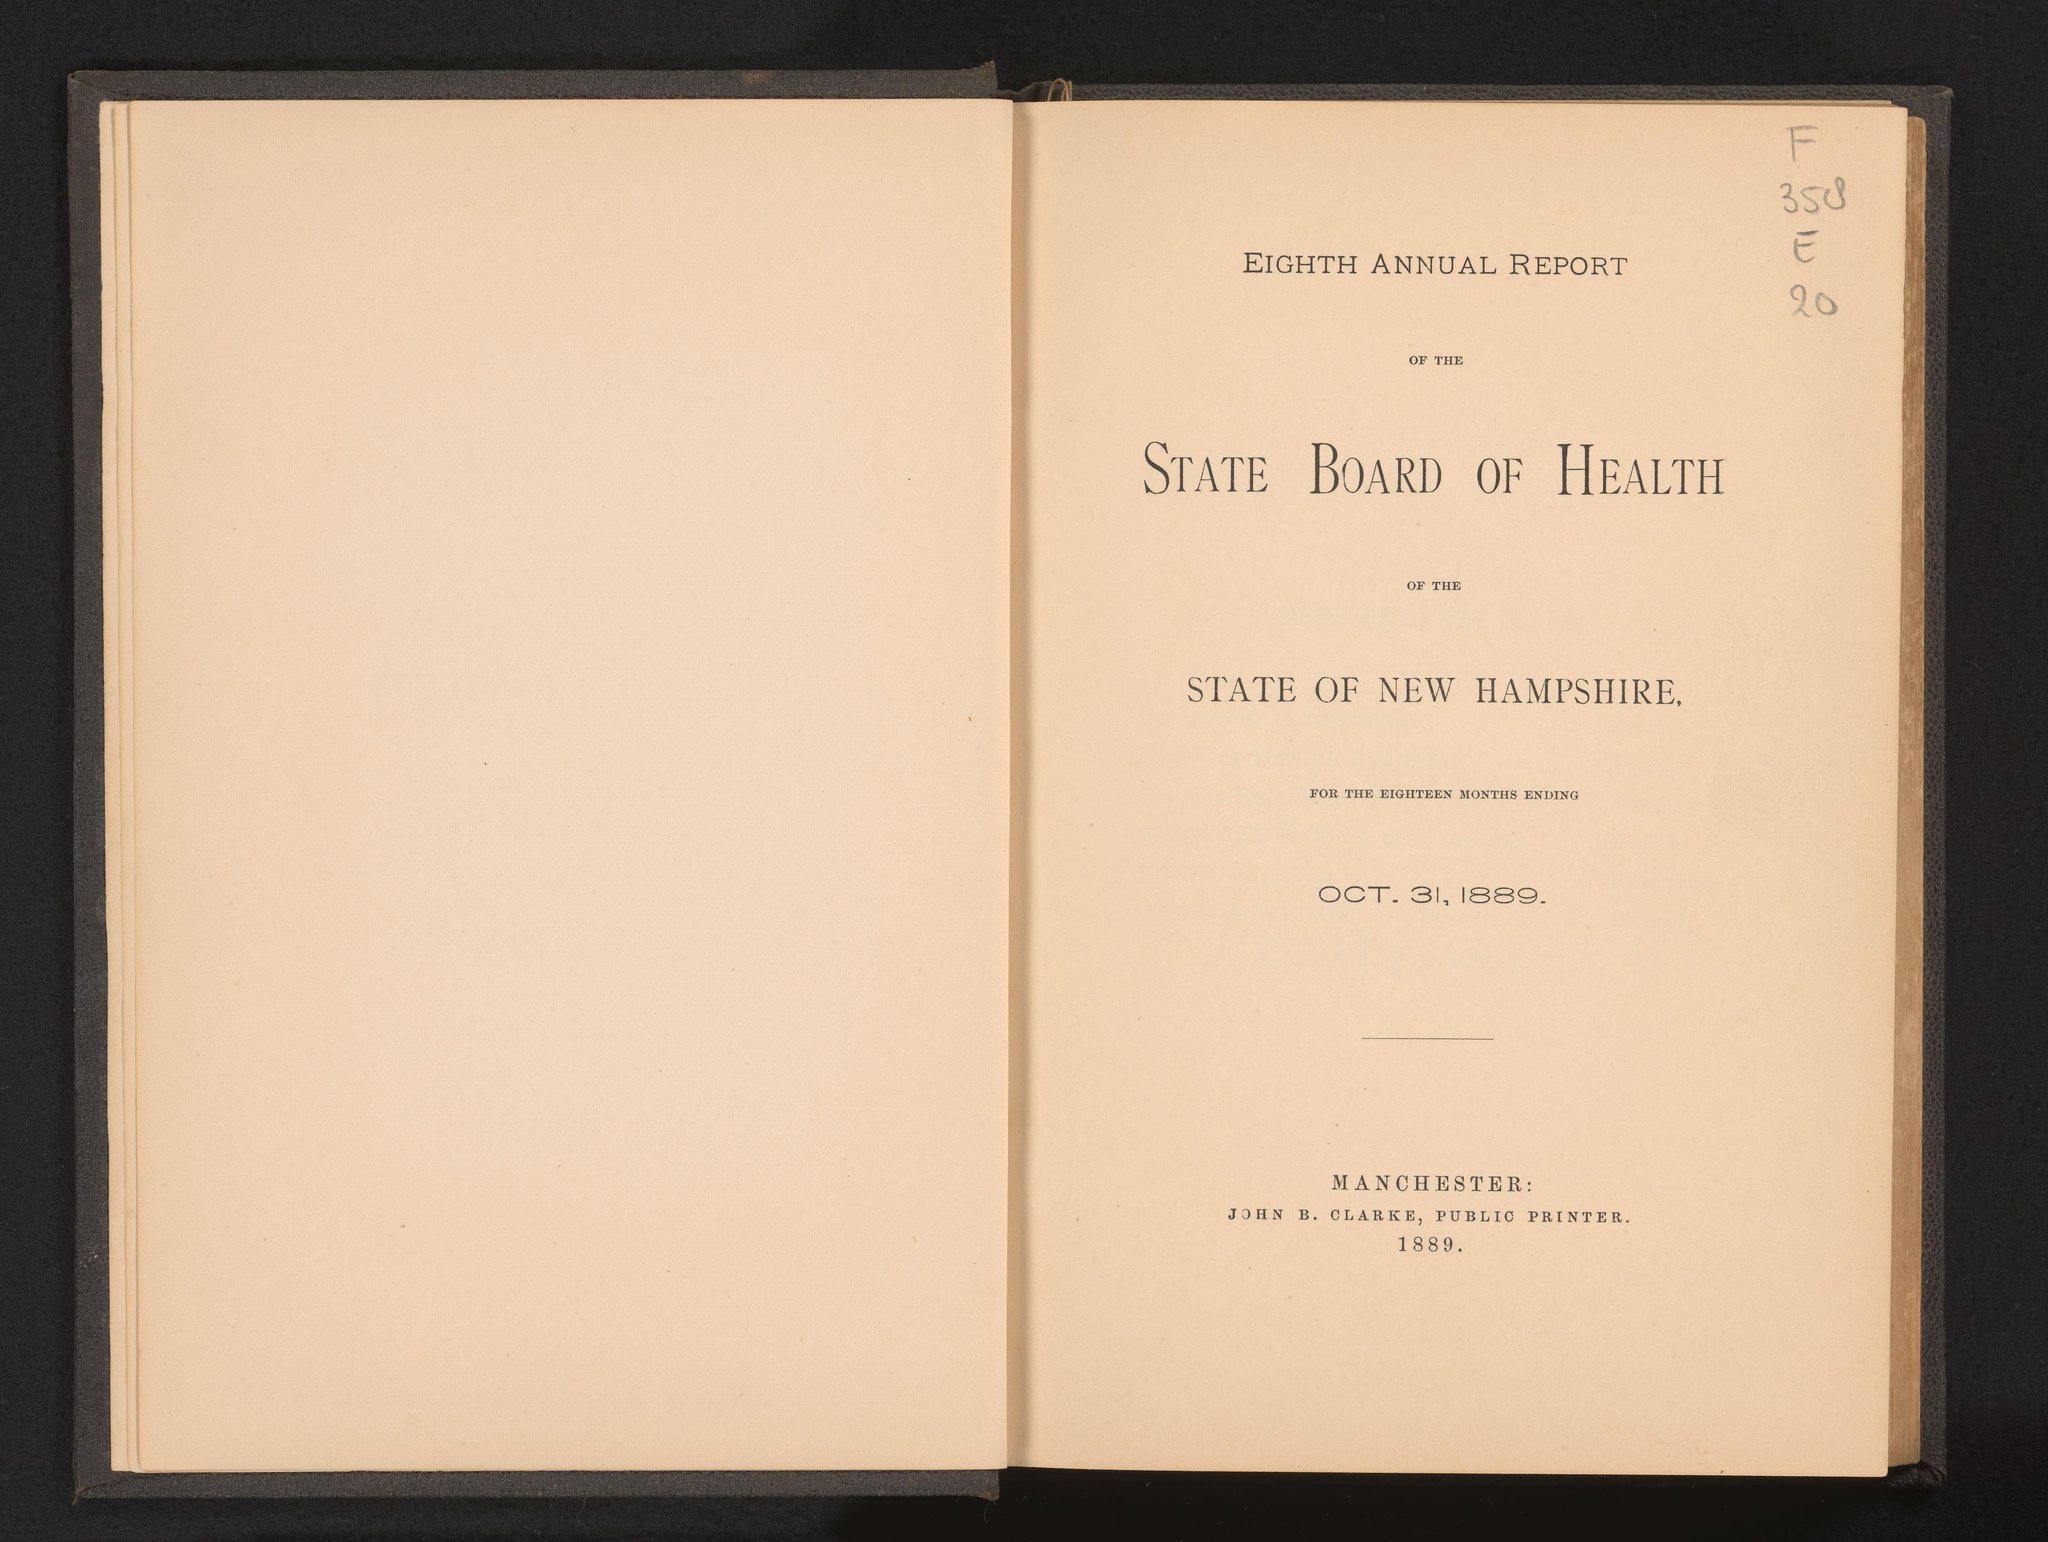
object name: book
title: Annual report of the State Board of Health of the State of New Hampshire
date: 1889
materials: cardboard, linen, paper, photographic support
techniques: cyanotype, printing